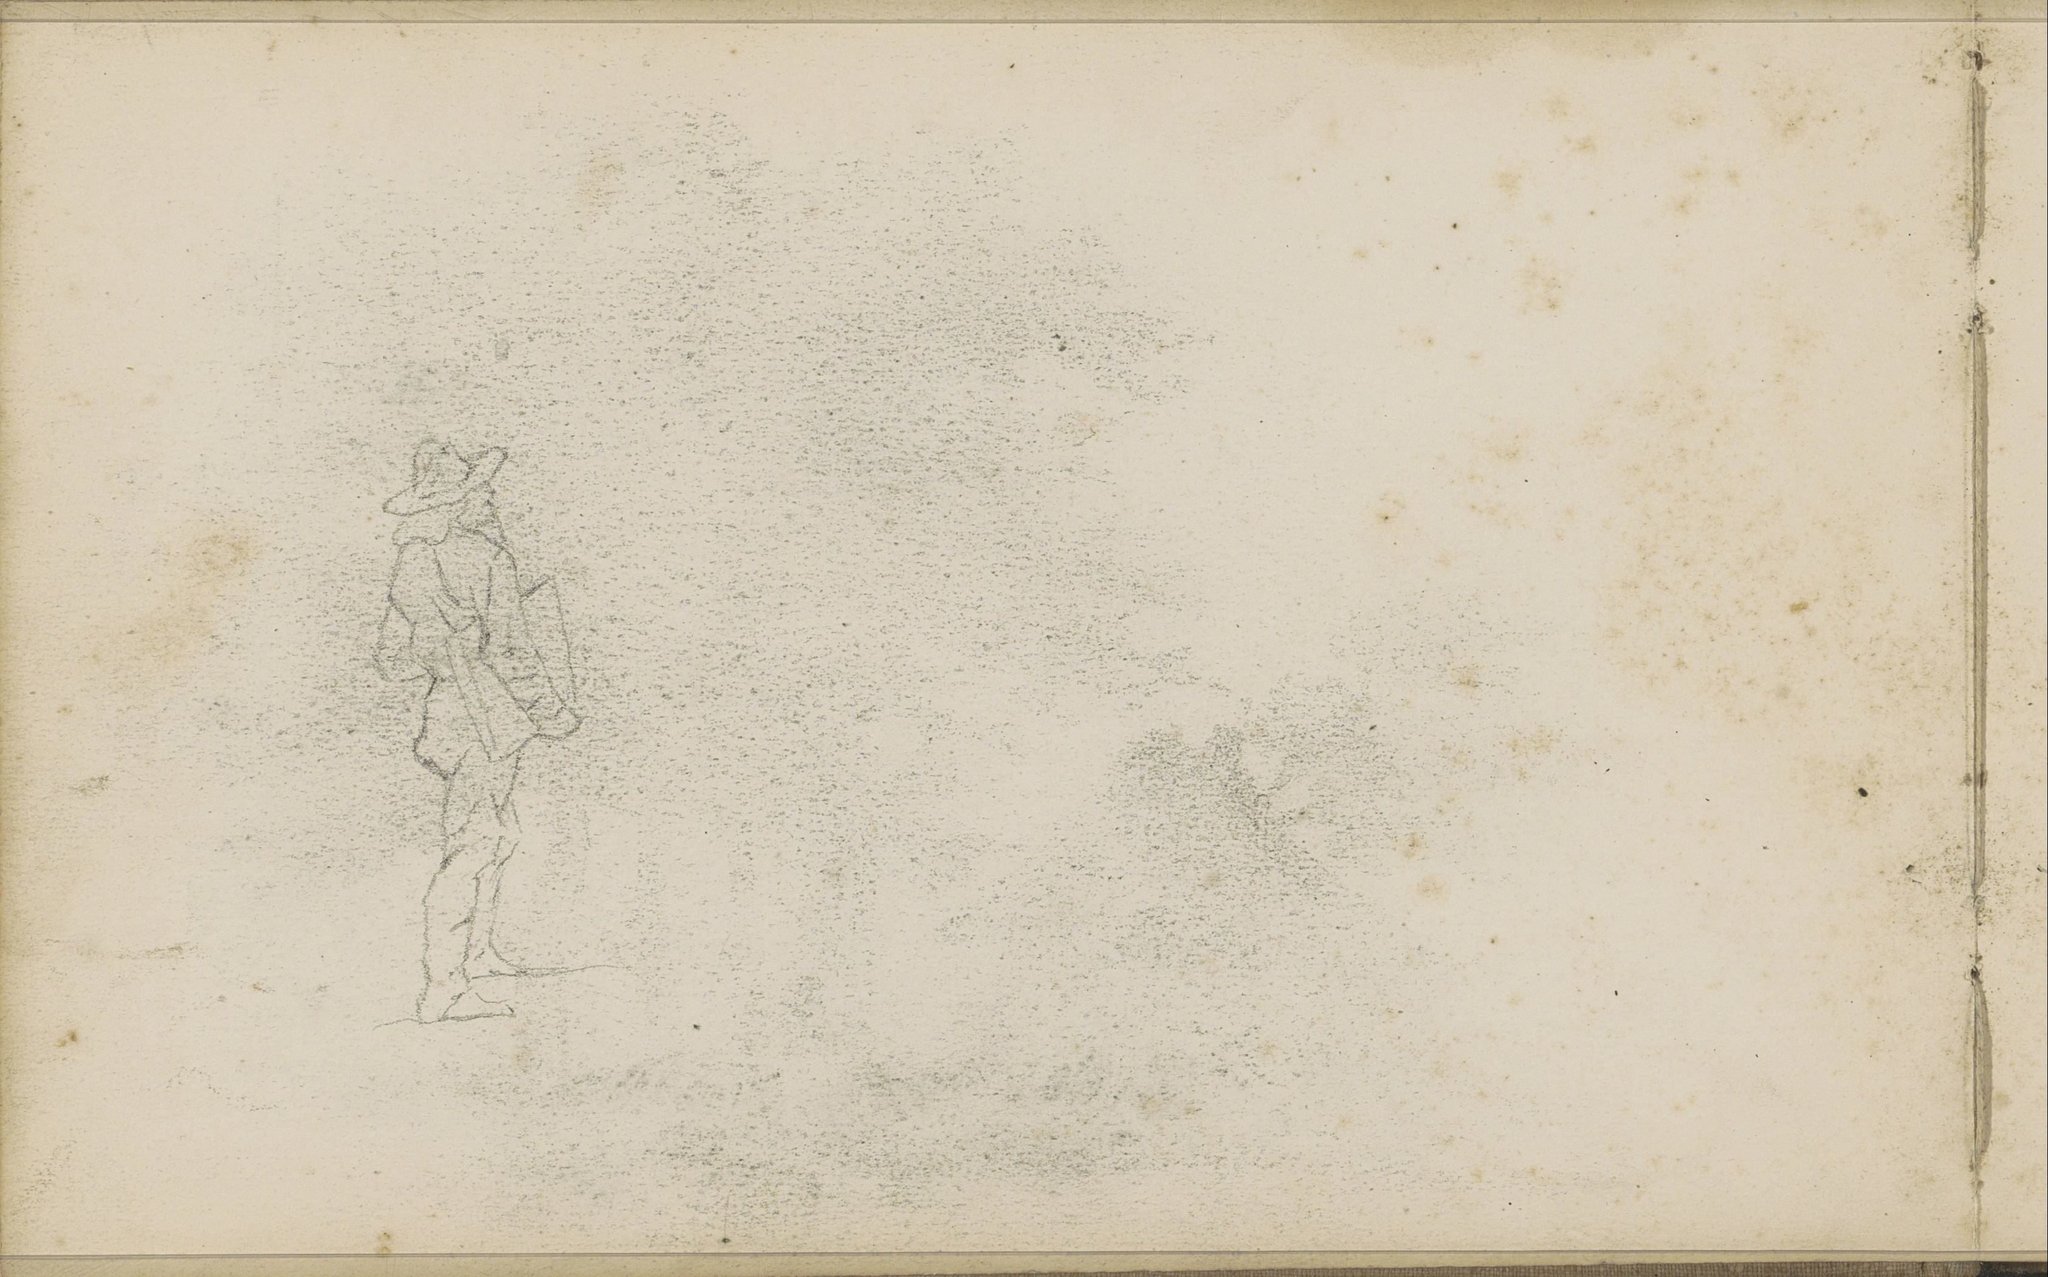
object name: sketchbook leaf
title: Man met een map onder de arm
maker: willem cornelis rip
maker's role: draughtsman, painter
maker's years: 1856-1922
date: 1874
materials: paper, pencil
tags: standing figure, carrying something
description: Blad 3 verso uit een schetsboek met 47 bladen.